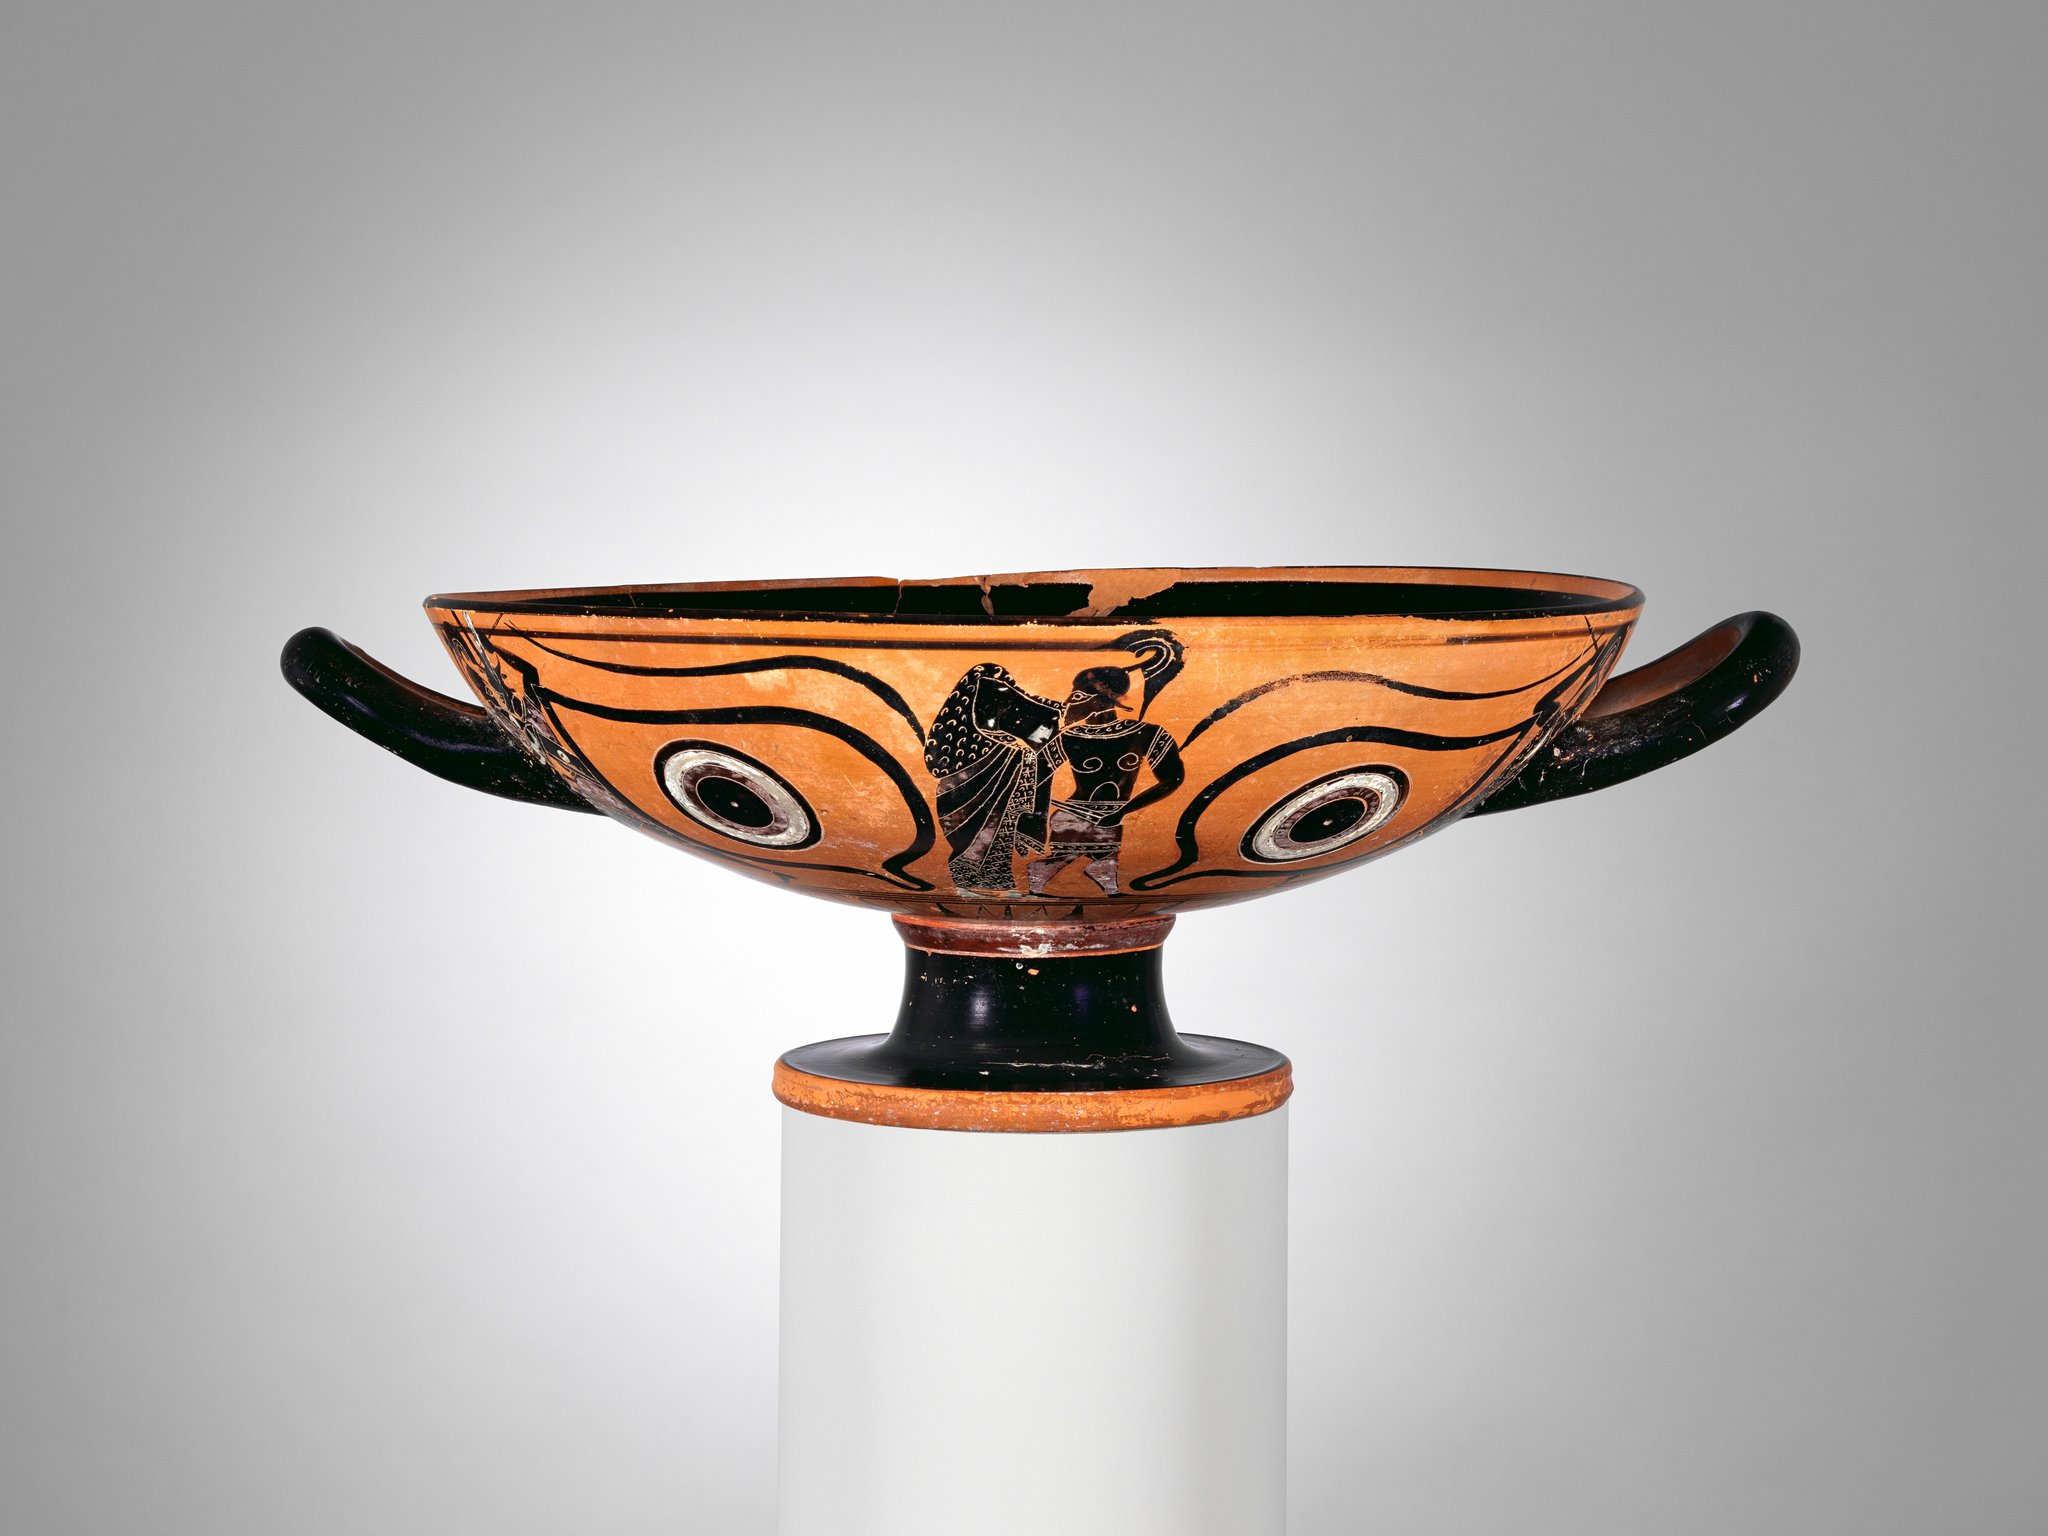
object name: kylix, eye cup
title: Terracotta kylix: eye-cup (drinking cup)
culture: greek, attic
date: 540-530 BCE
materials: terracotta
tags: women,warriors